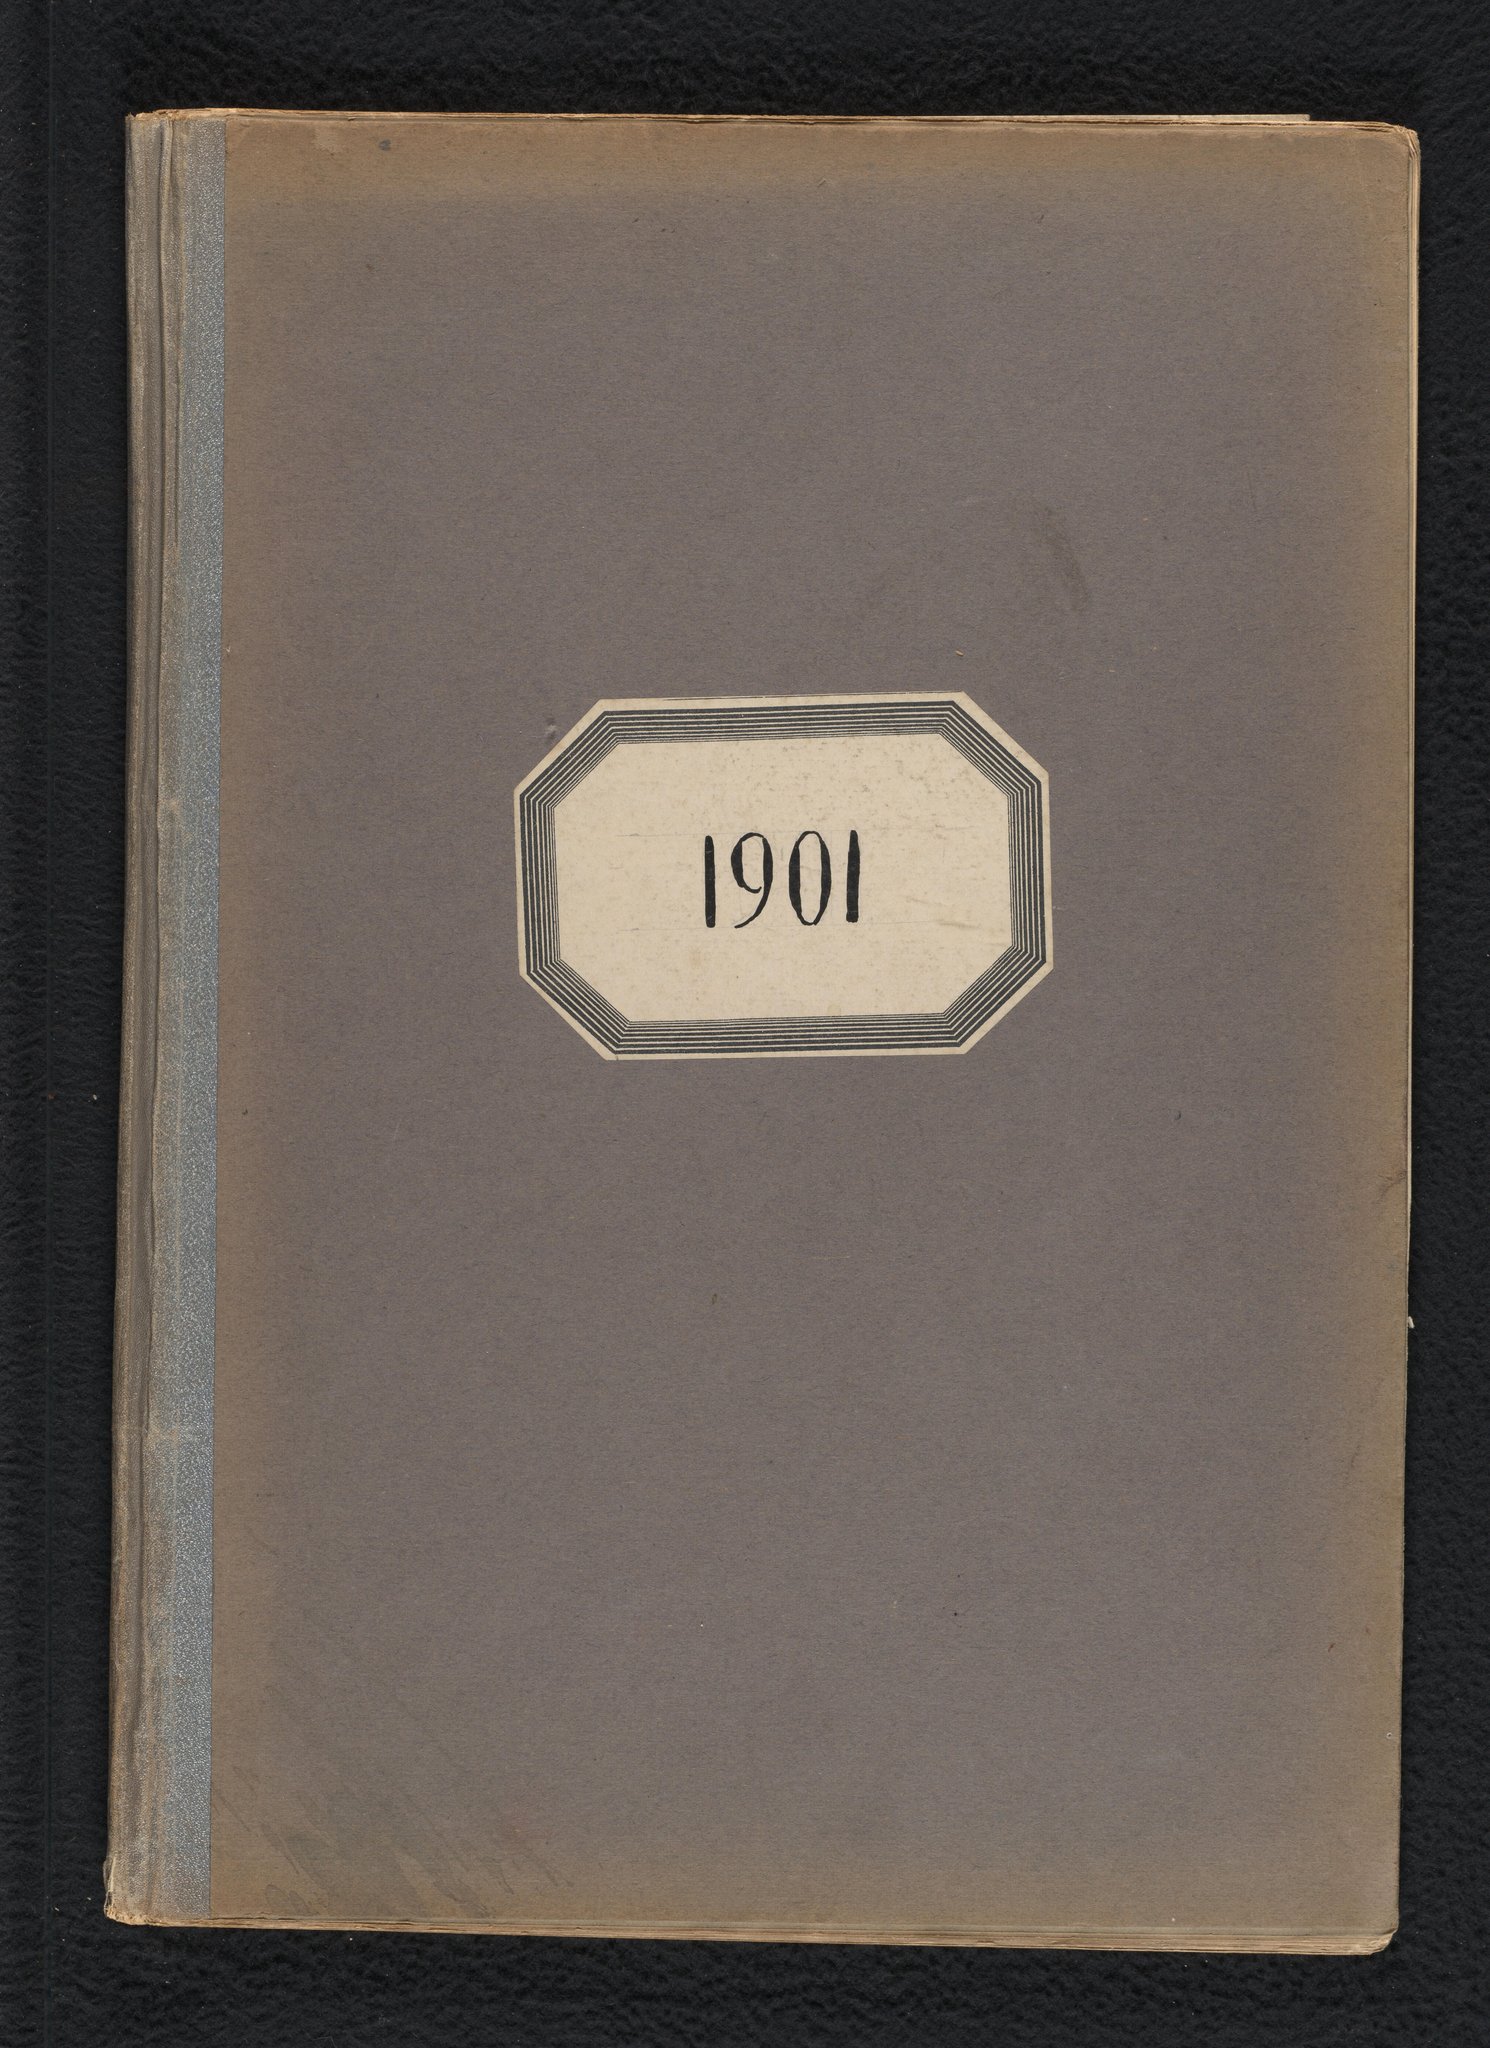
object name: cartoon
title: Spotprenten uit 'De Amsterdammer' van het jaar 1901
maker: johan braakensiek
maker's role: draughtsman, print maker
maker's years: 1858-1940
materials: paper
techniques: lithograph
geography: amsterdam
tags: political caricatures and satires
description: Bundel van 53 spotprenten van Braakensiek gepubliceerd als bijvoegsel bij 'De Amsterdammer' in het jaar 1901. Bundel geplakt in slappe omslag van grijsgroen karton met handgeschreven etiket '1901'.